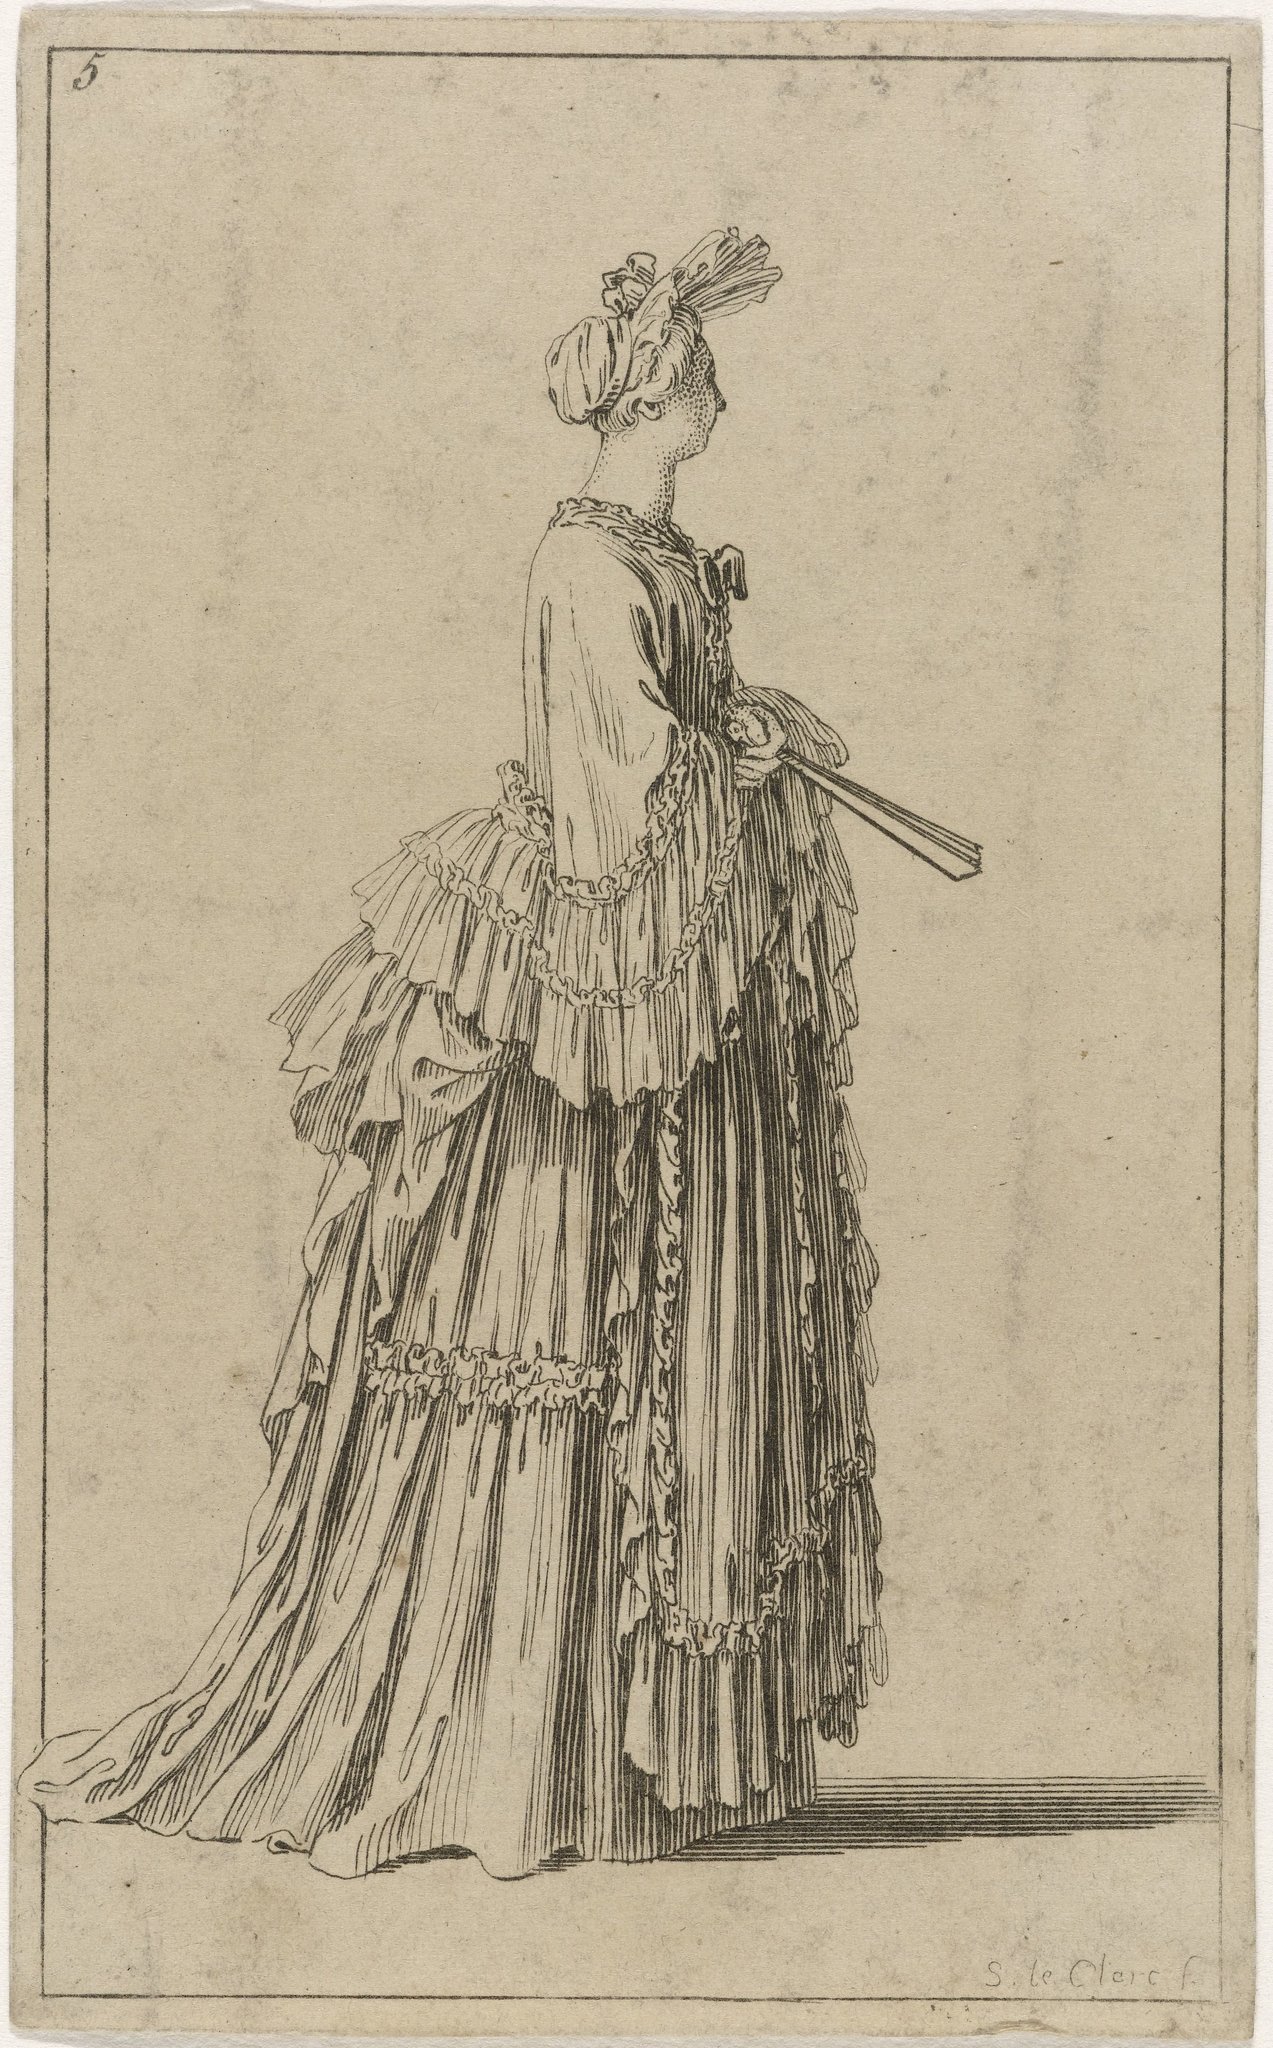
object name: print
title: Dame met fontange, in japon met falbalas, naar rechts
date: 1685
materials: paper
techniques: etching